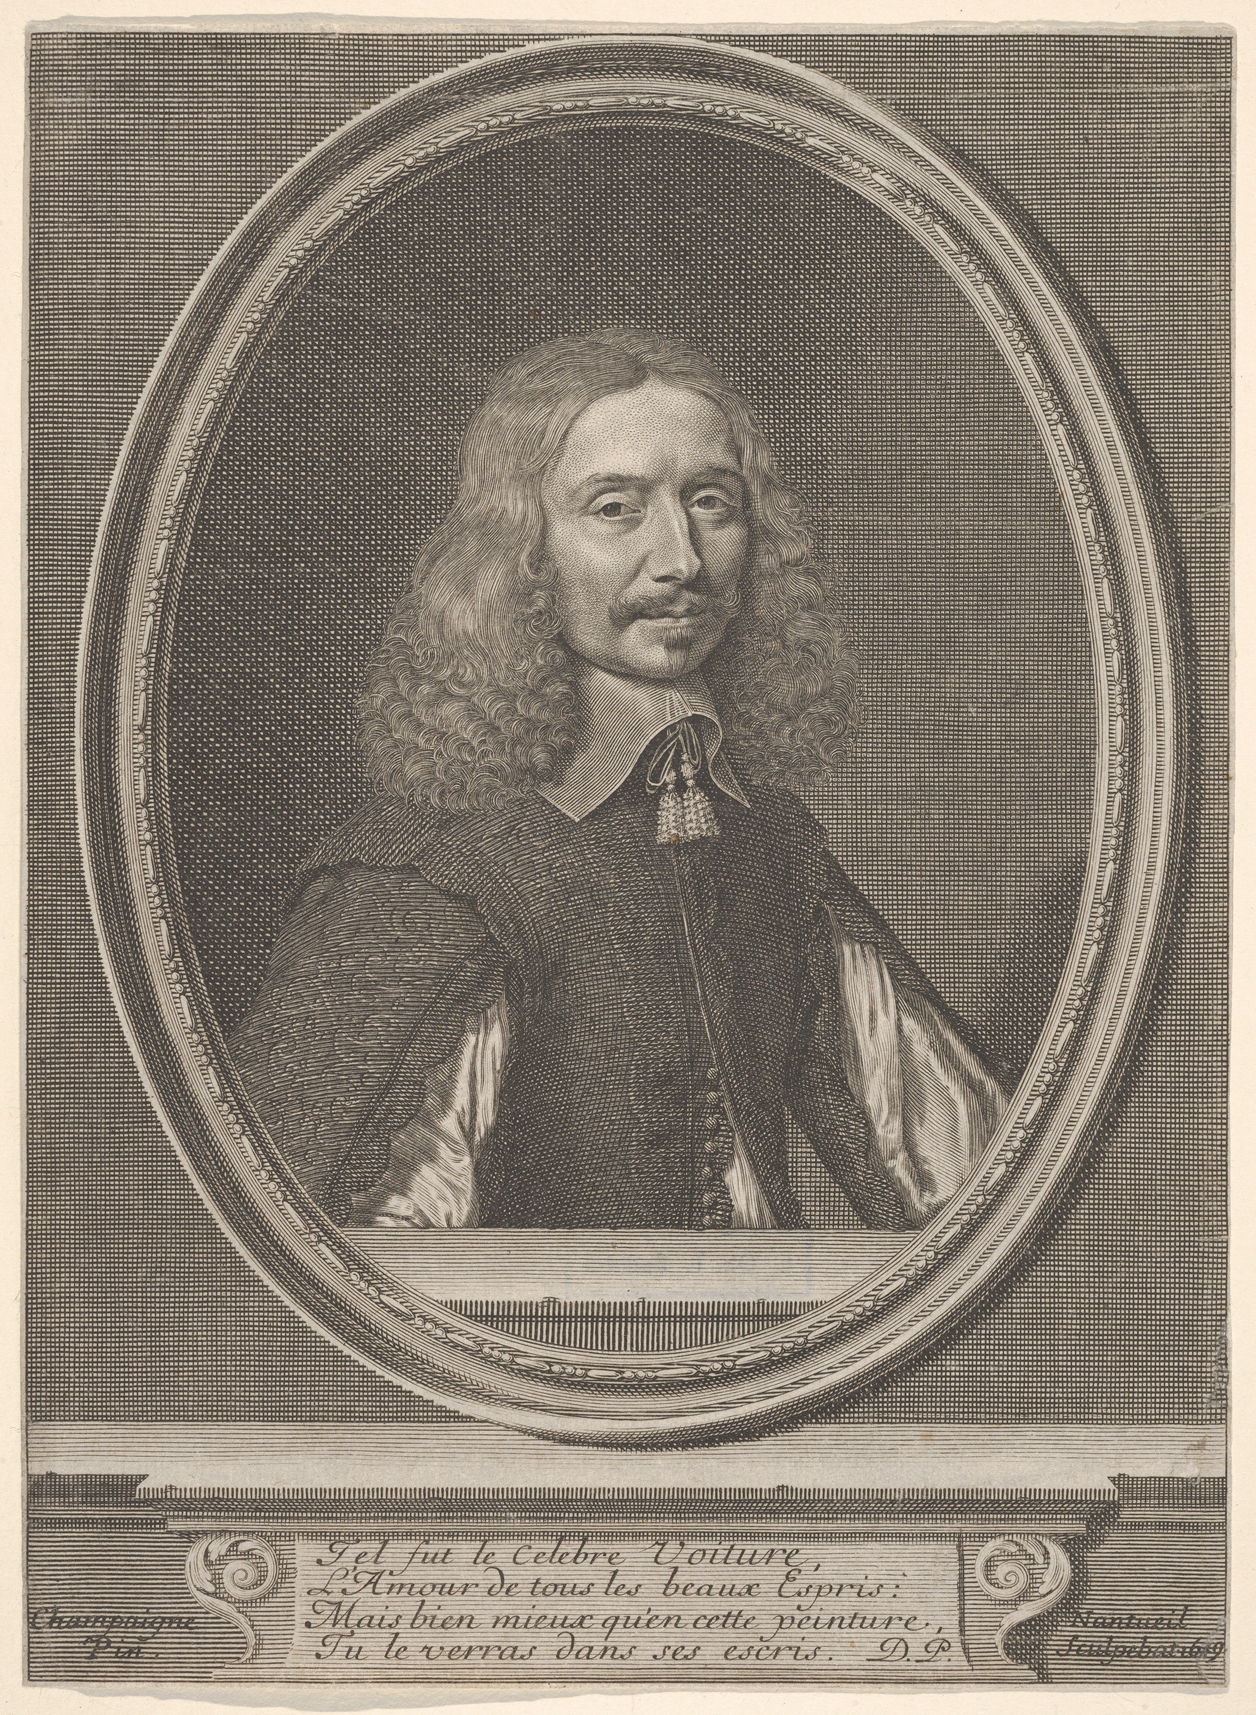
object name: print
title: Vincent Voiture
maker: robert nanteuil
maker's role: artist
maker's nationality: french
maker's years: 1623-1678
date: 1649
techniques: engraving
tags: men,portraits,poets